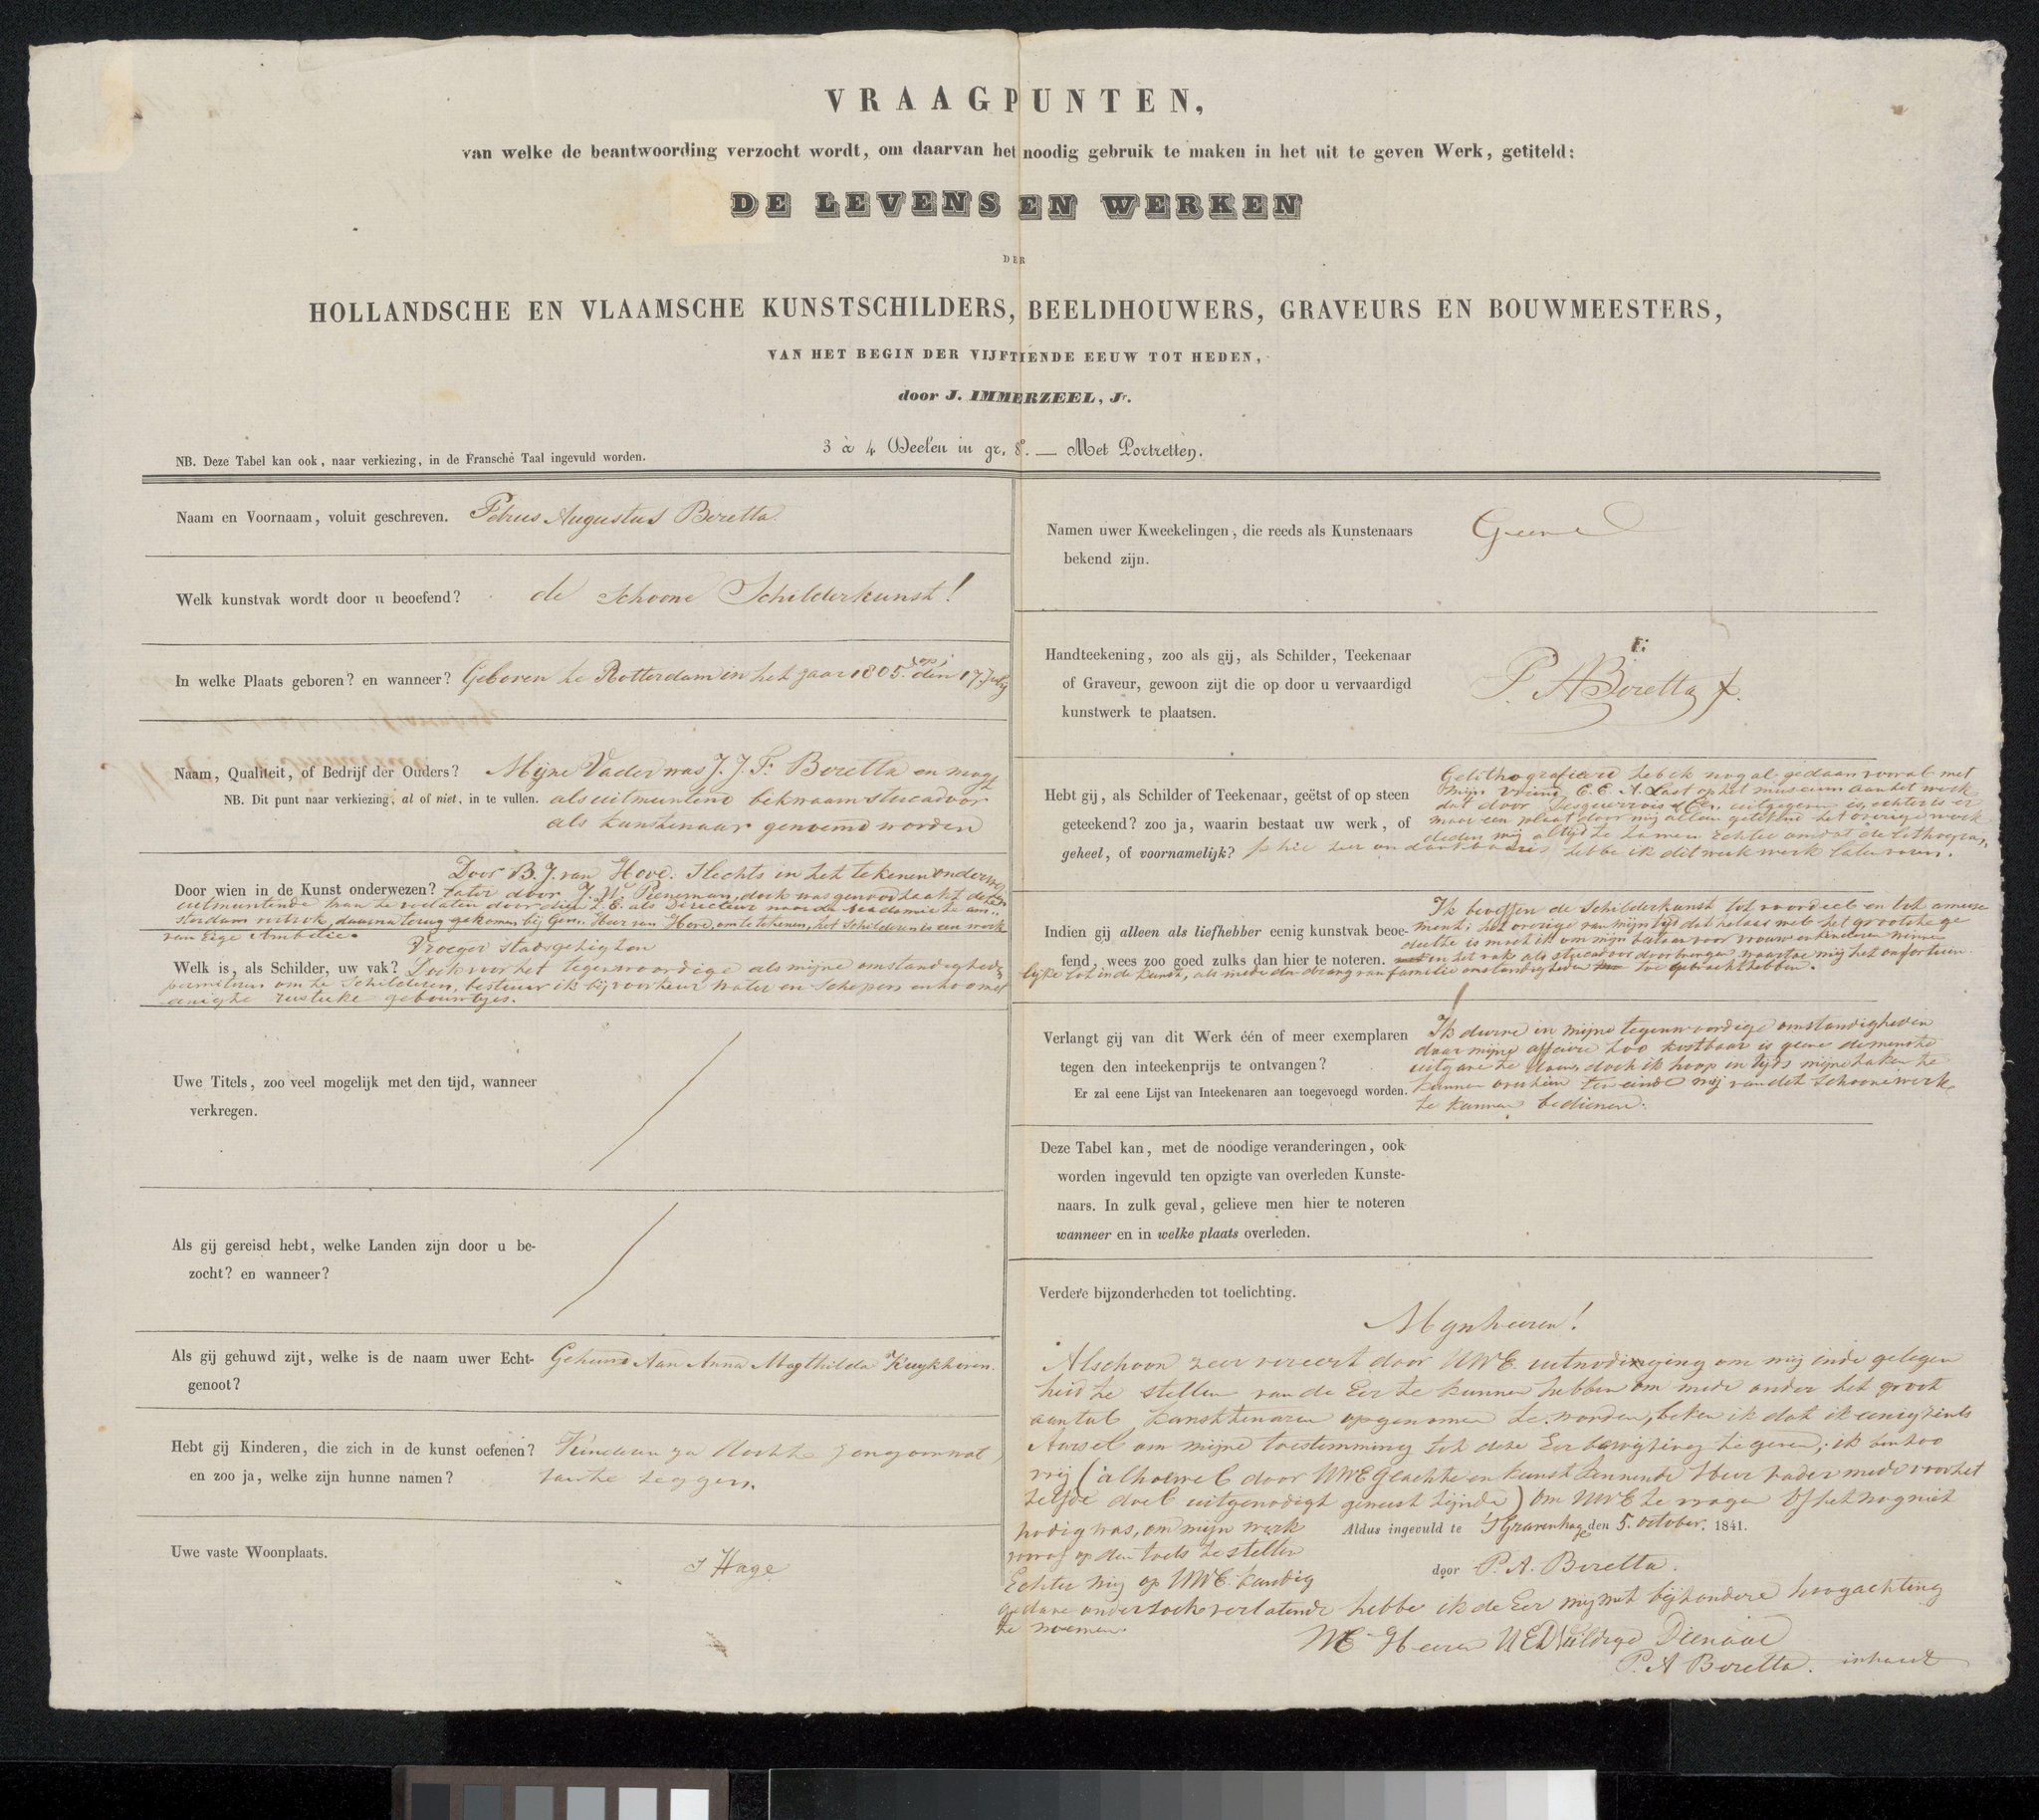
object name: manuscript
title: Enquêteformulier ingevuld door Petrus Augustus Beretta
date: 1841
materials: ink, paper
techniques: pen, printing, writing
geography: the hague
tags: rotterdam, the hague, draughtsman, petrus augustus beretta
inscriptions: inscription: ‘Vraagpunten,/ van welke de beantwoording verzocht wordt, om daarvan het noodig gebruik te maken in het uit te geven Werk, getiteld: De levens en werken/ der Hollandsche en Vlaamsche kunstschilders, beeldhouwers,/ graveurs en bouwmeesters, van het begin der vijftiende eeuw tot heden/ door J. Immerzeel, Jr.’, watermark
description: Opgenomen in: Immerzeel, J. Jr., De levens en werken der Hollandsche en Vlaamsche kunstschilders, beeldhouwers, graveurs en bouwmeesters, van het begin der vijftiende eeuw tot heden, Amsterdam: J.C. van Kesteren, 1842-1843.